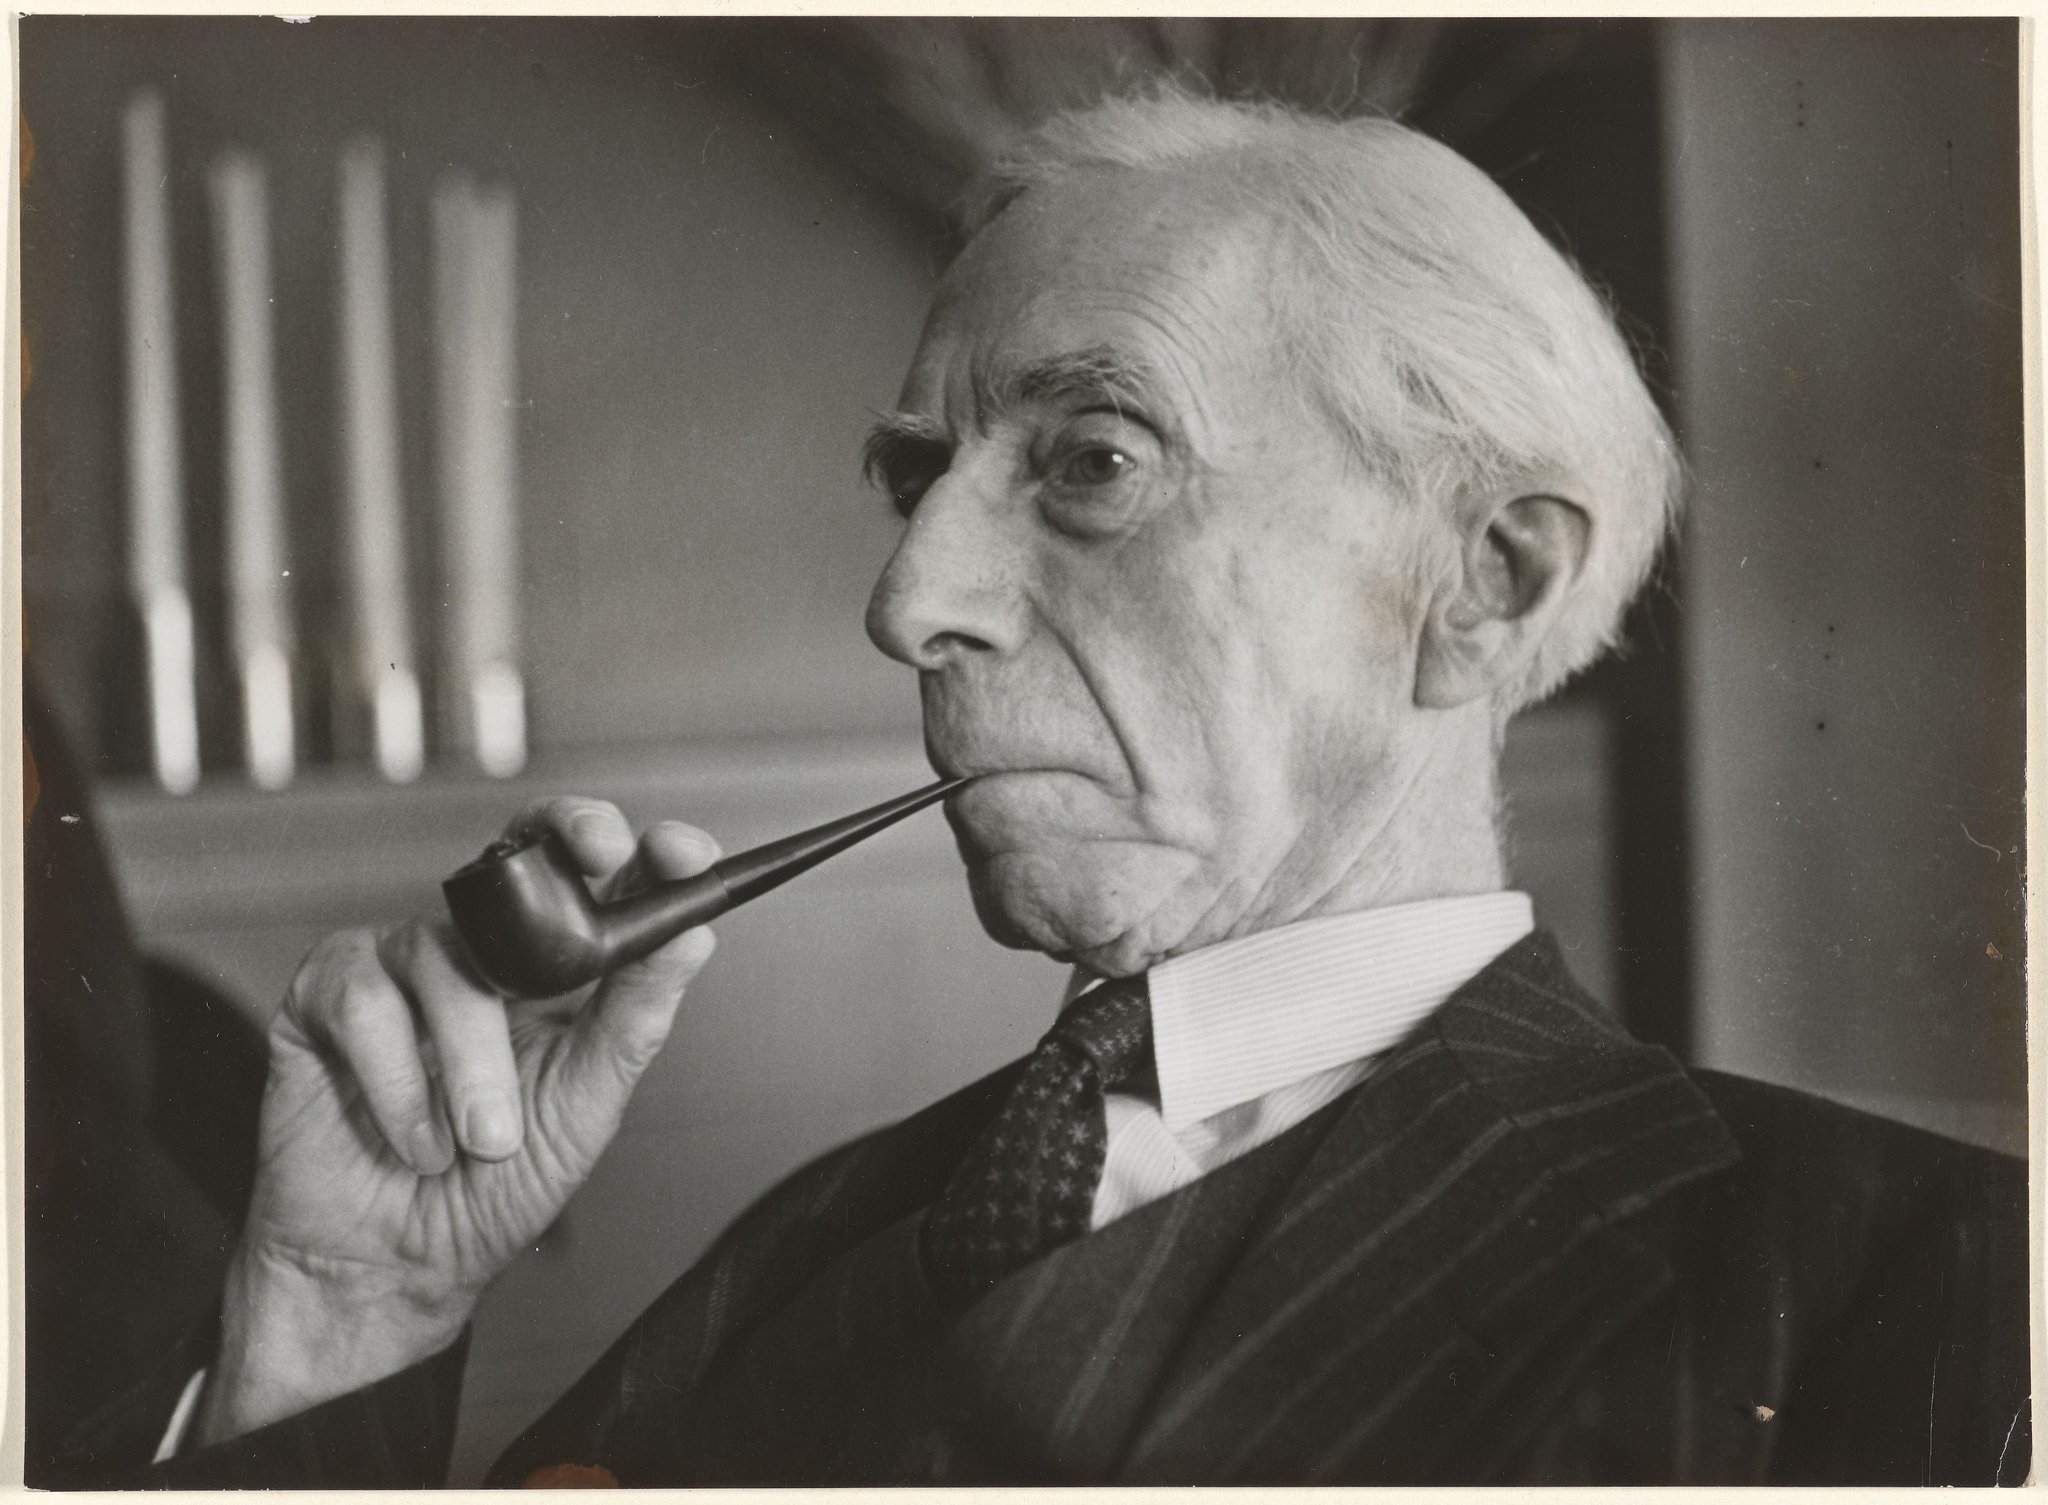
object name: photograph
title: Bertrand Russell op persconferentie New York, 1950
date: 1950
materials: photographic support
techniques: gelatin silver print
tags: wetenschapper, bertrand russell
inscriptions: annotation: ‘Nobel prize winner speaks...’